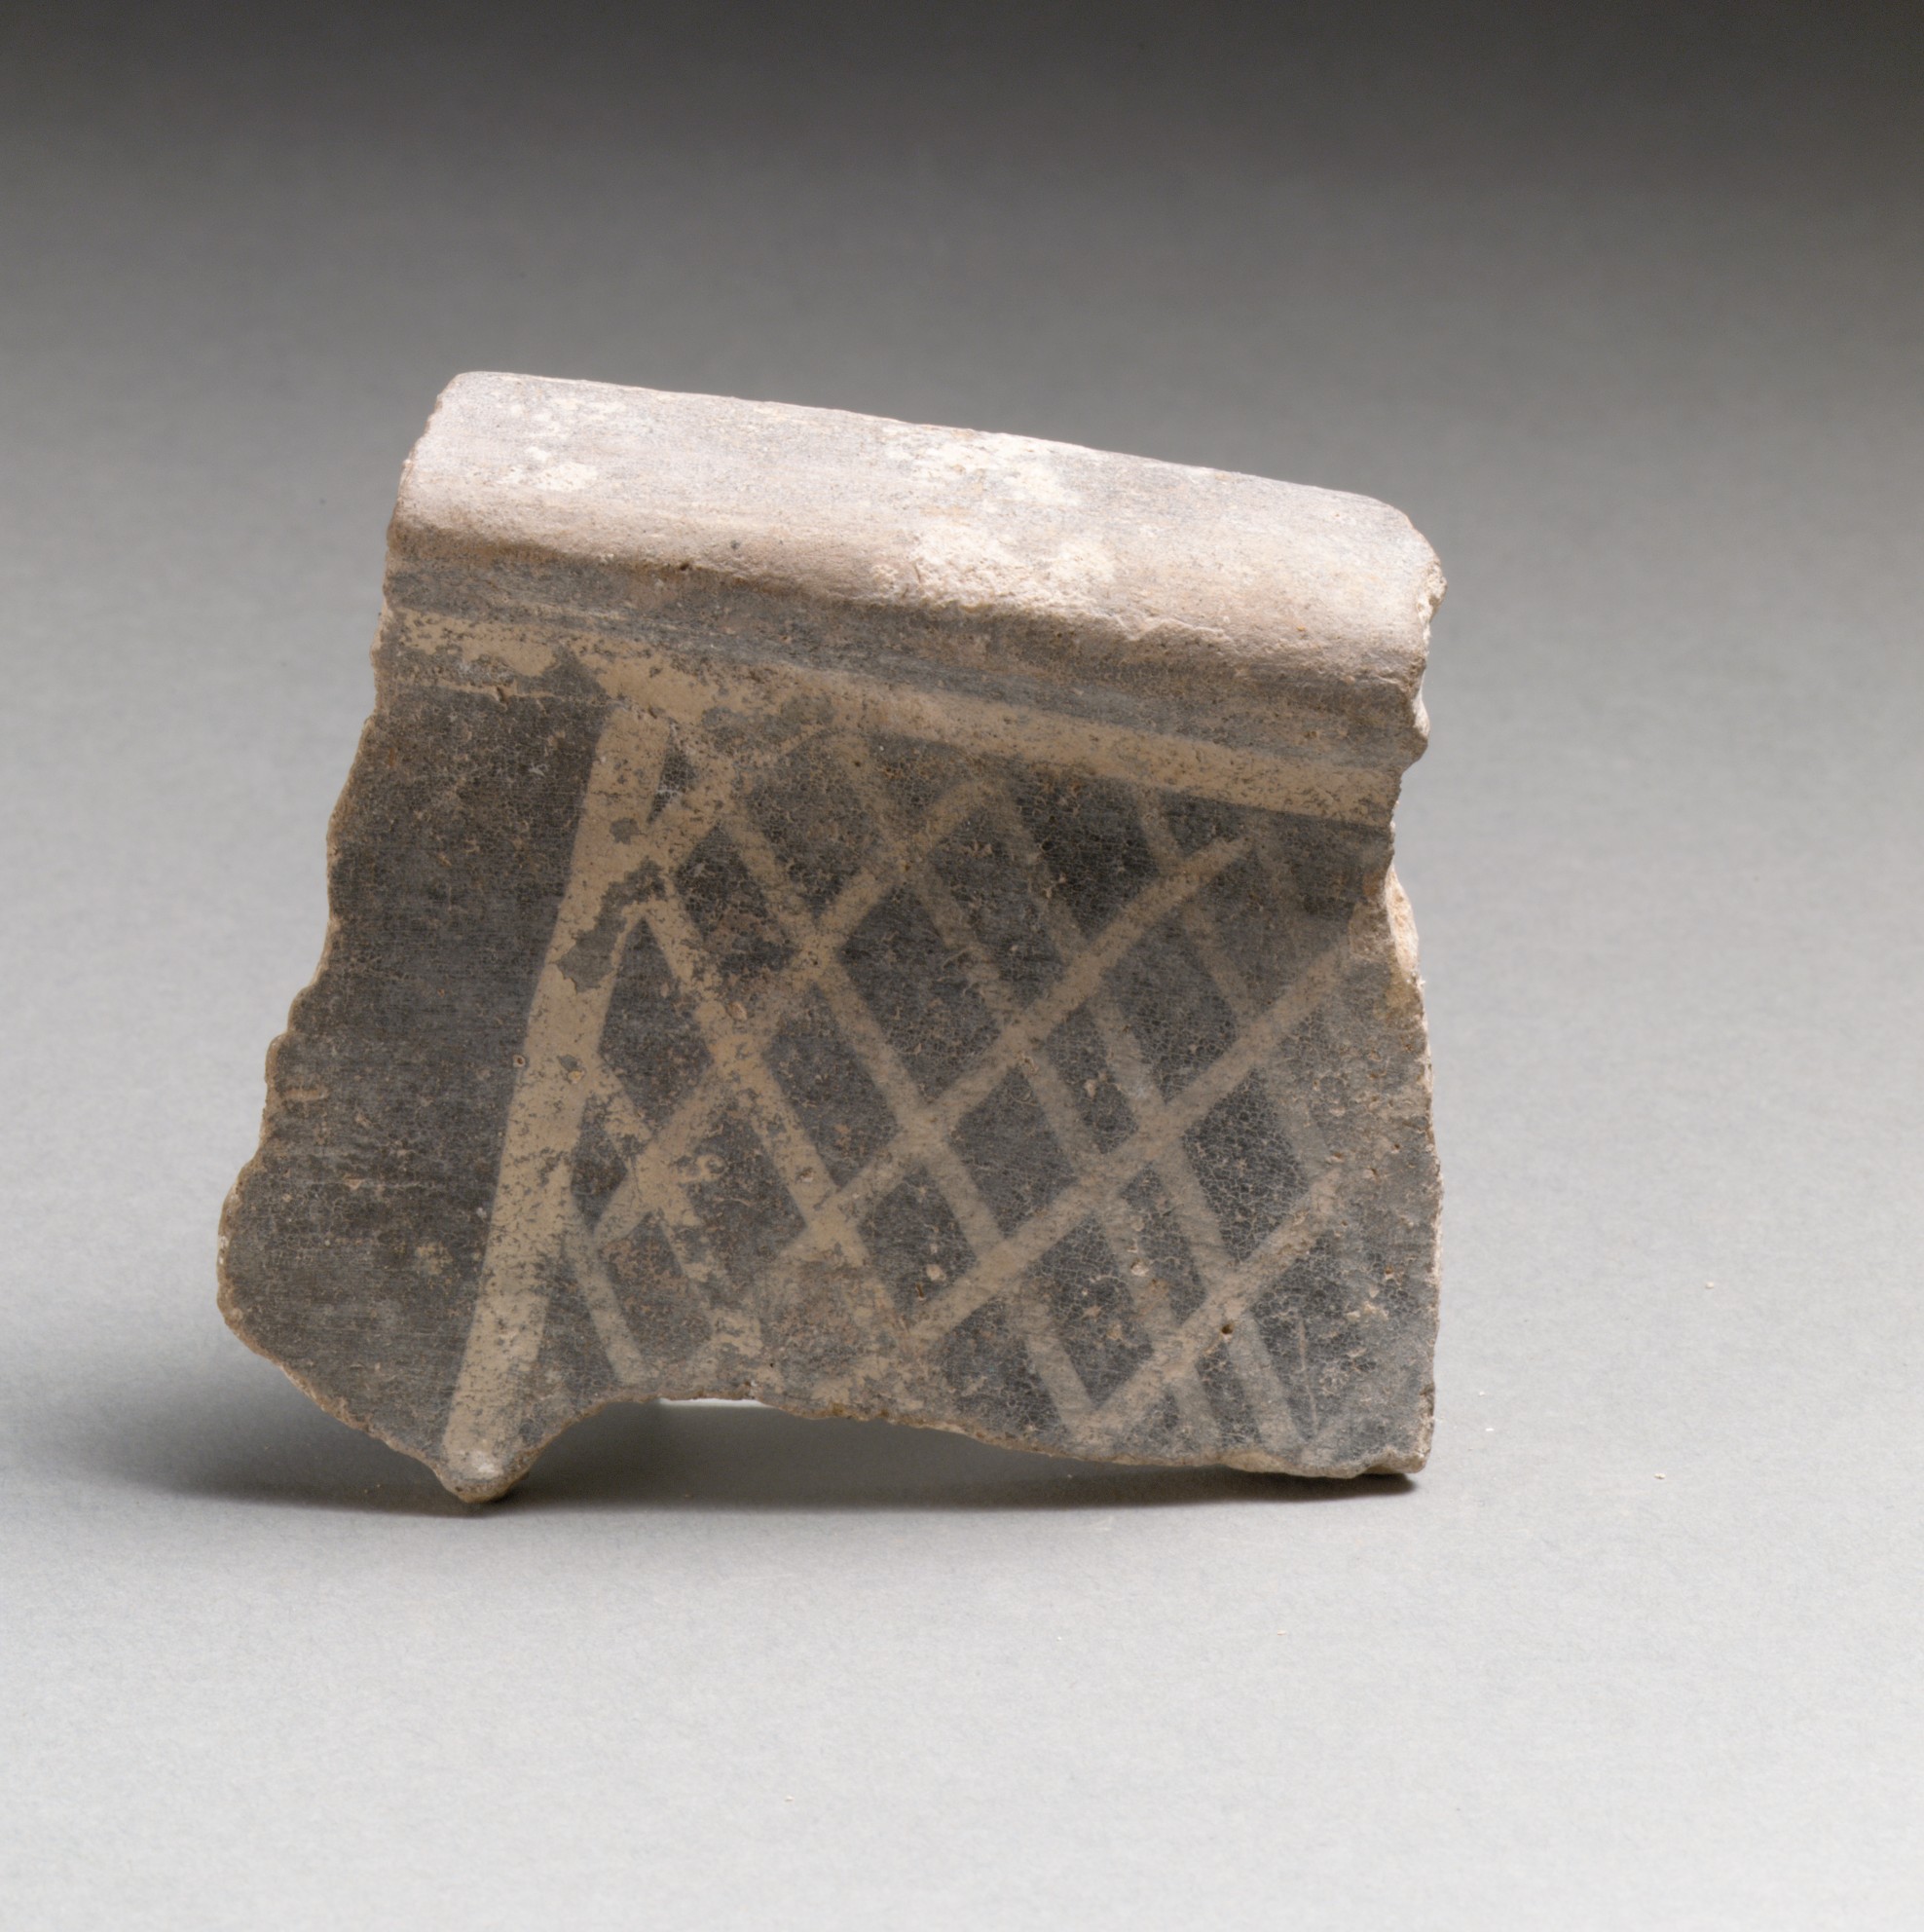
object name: vase fragment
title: Terracotta rim fragment with cross-hatching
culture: minoan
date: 2300-2100 BCE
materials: terracotta